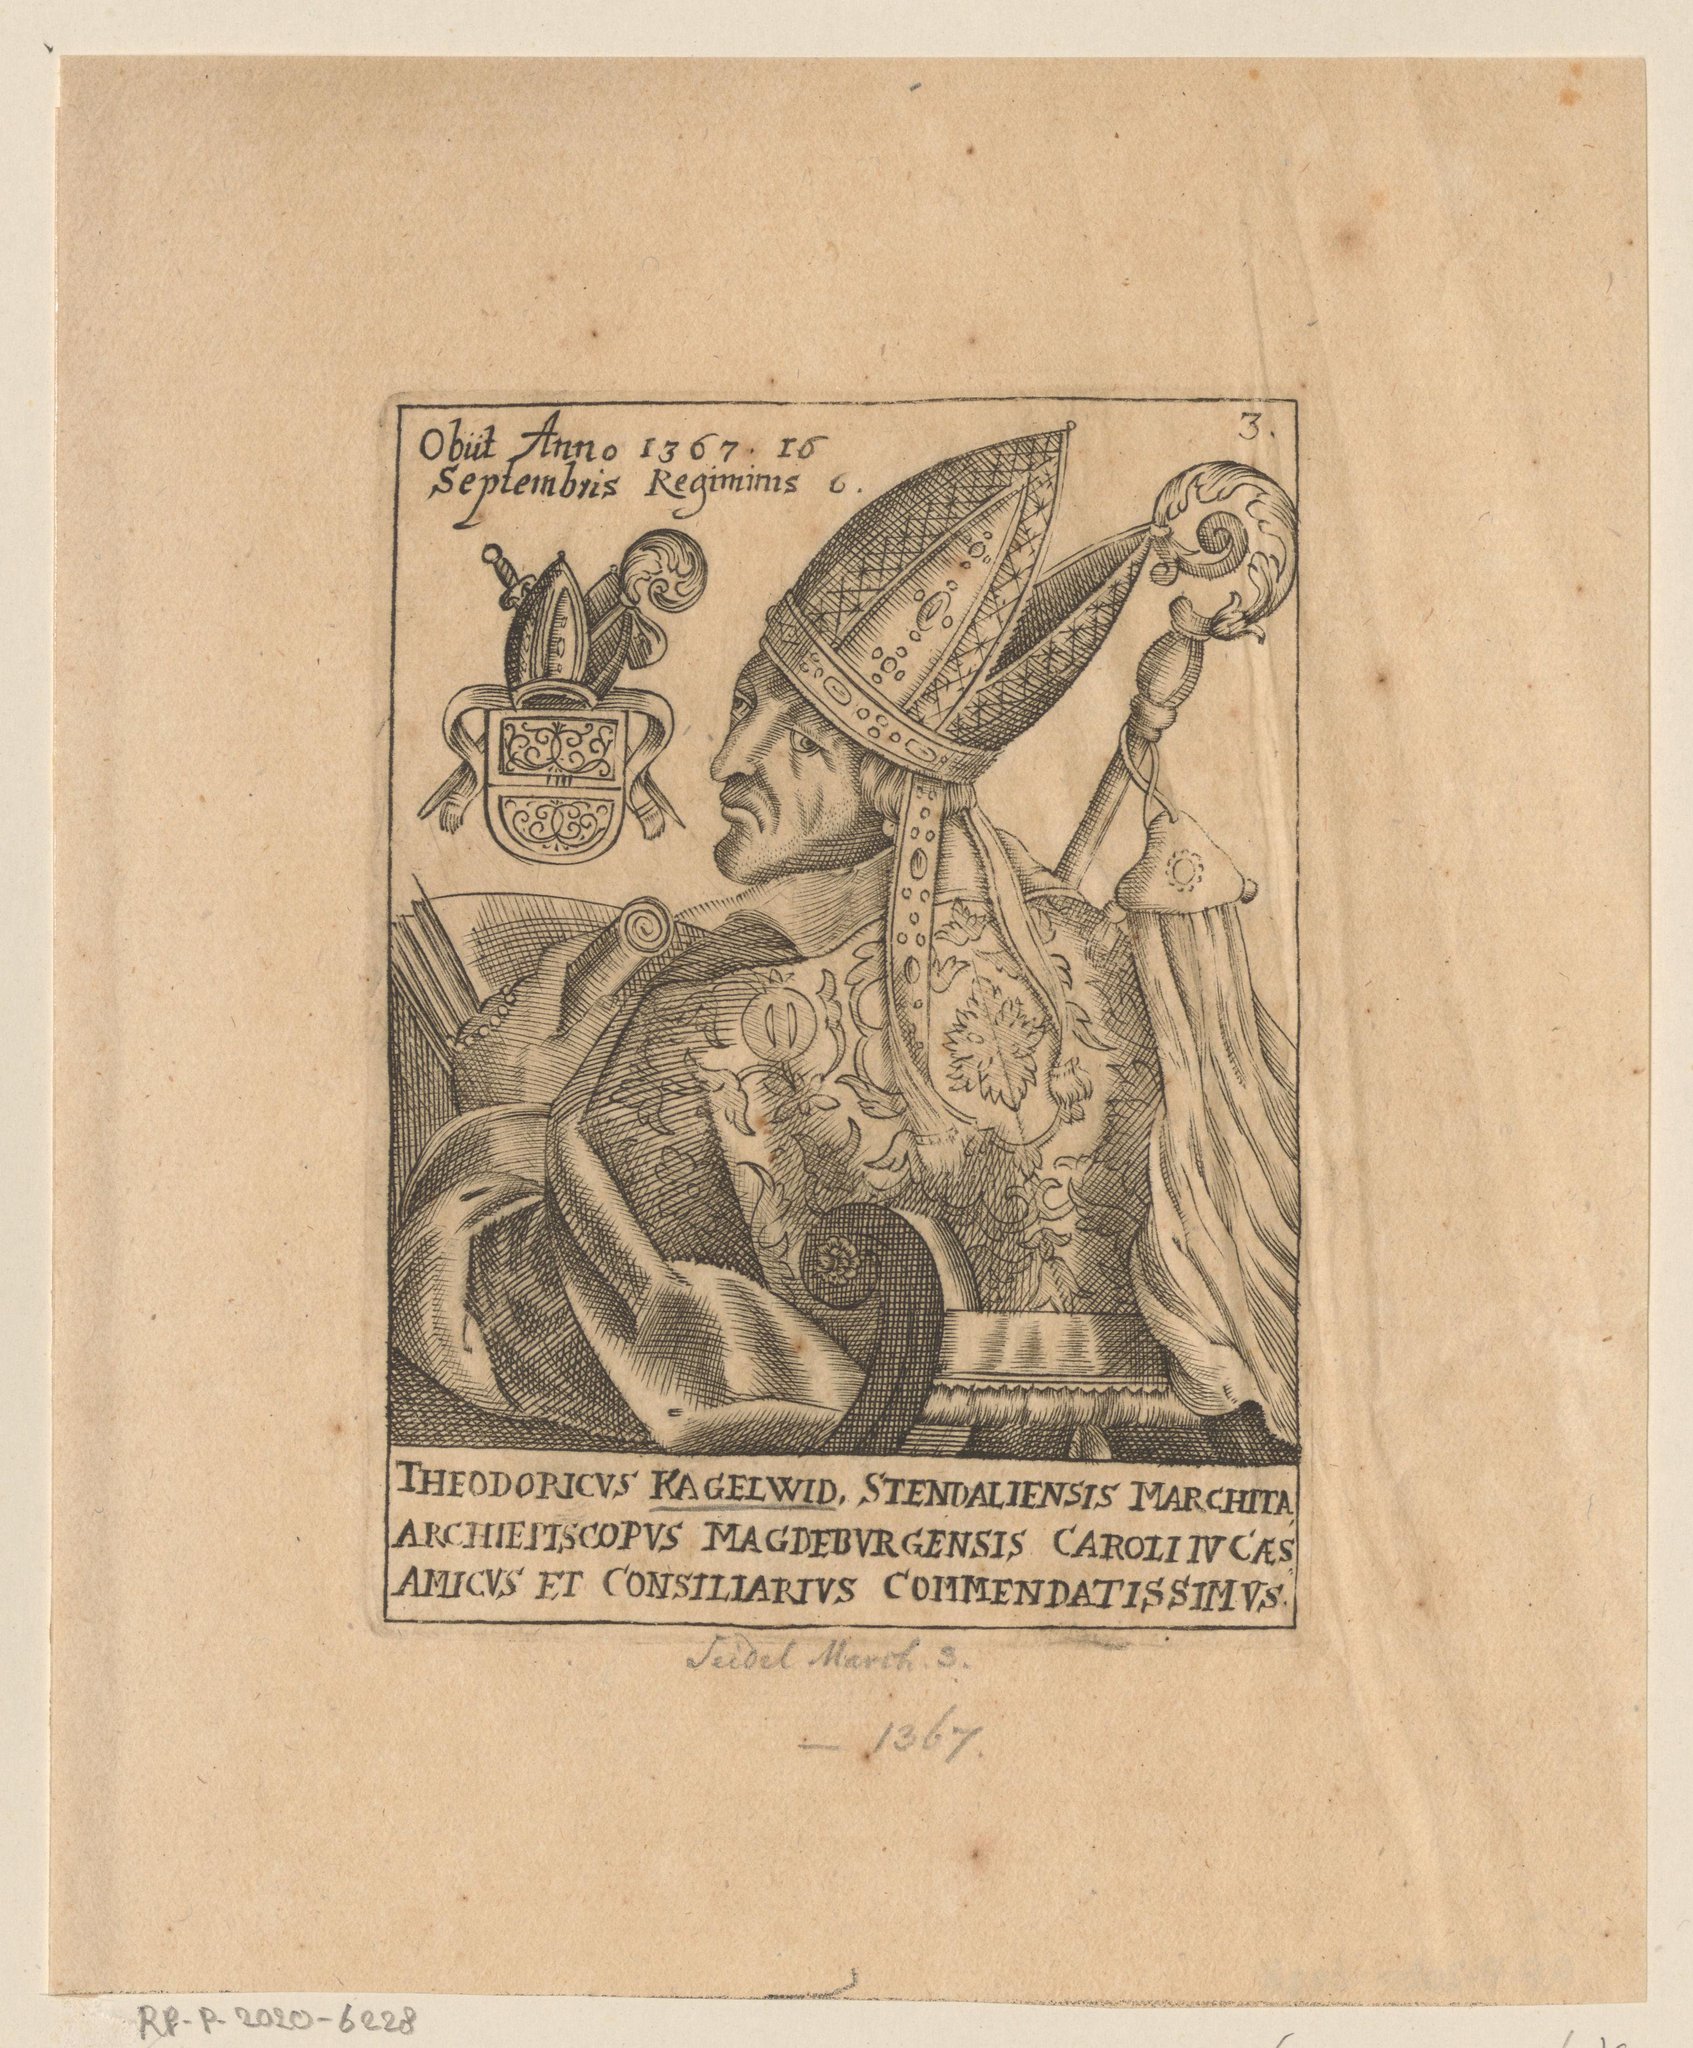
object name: print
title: Portret van Dietrich Kagelwid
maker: Anonymous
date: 1751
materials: paper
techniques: engraving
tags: historical persons, armorial bearing, heraldry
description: Prent mogelijk uit: Küster, Georg Gottfried. Martin Friedrich Seidels Bilder-Sammlung in welcher hundert, gröstentheils in der Mark Brandenburg (…). Berlijn: Buchladen bey der Real-Schule, 1751.